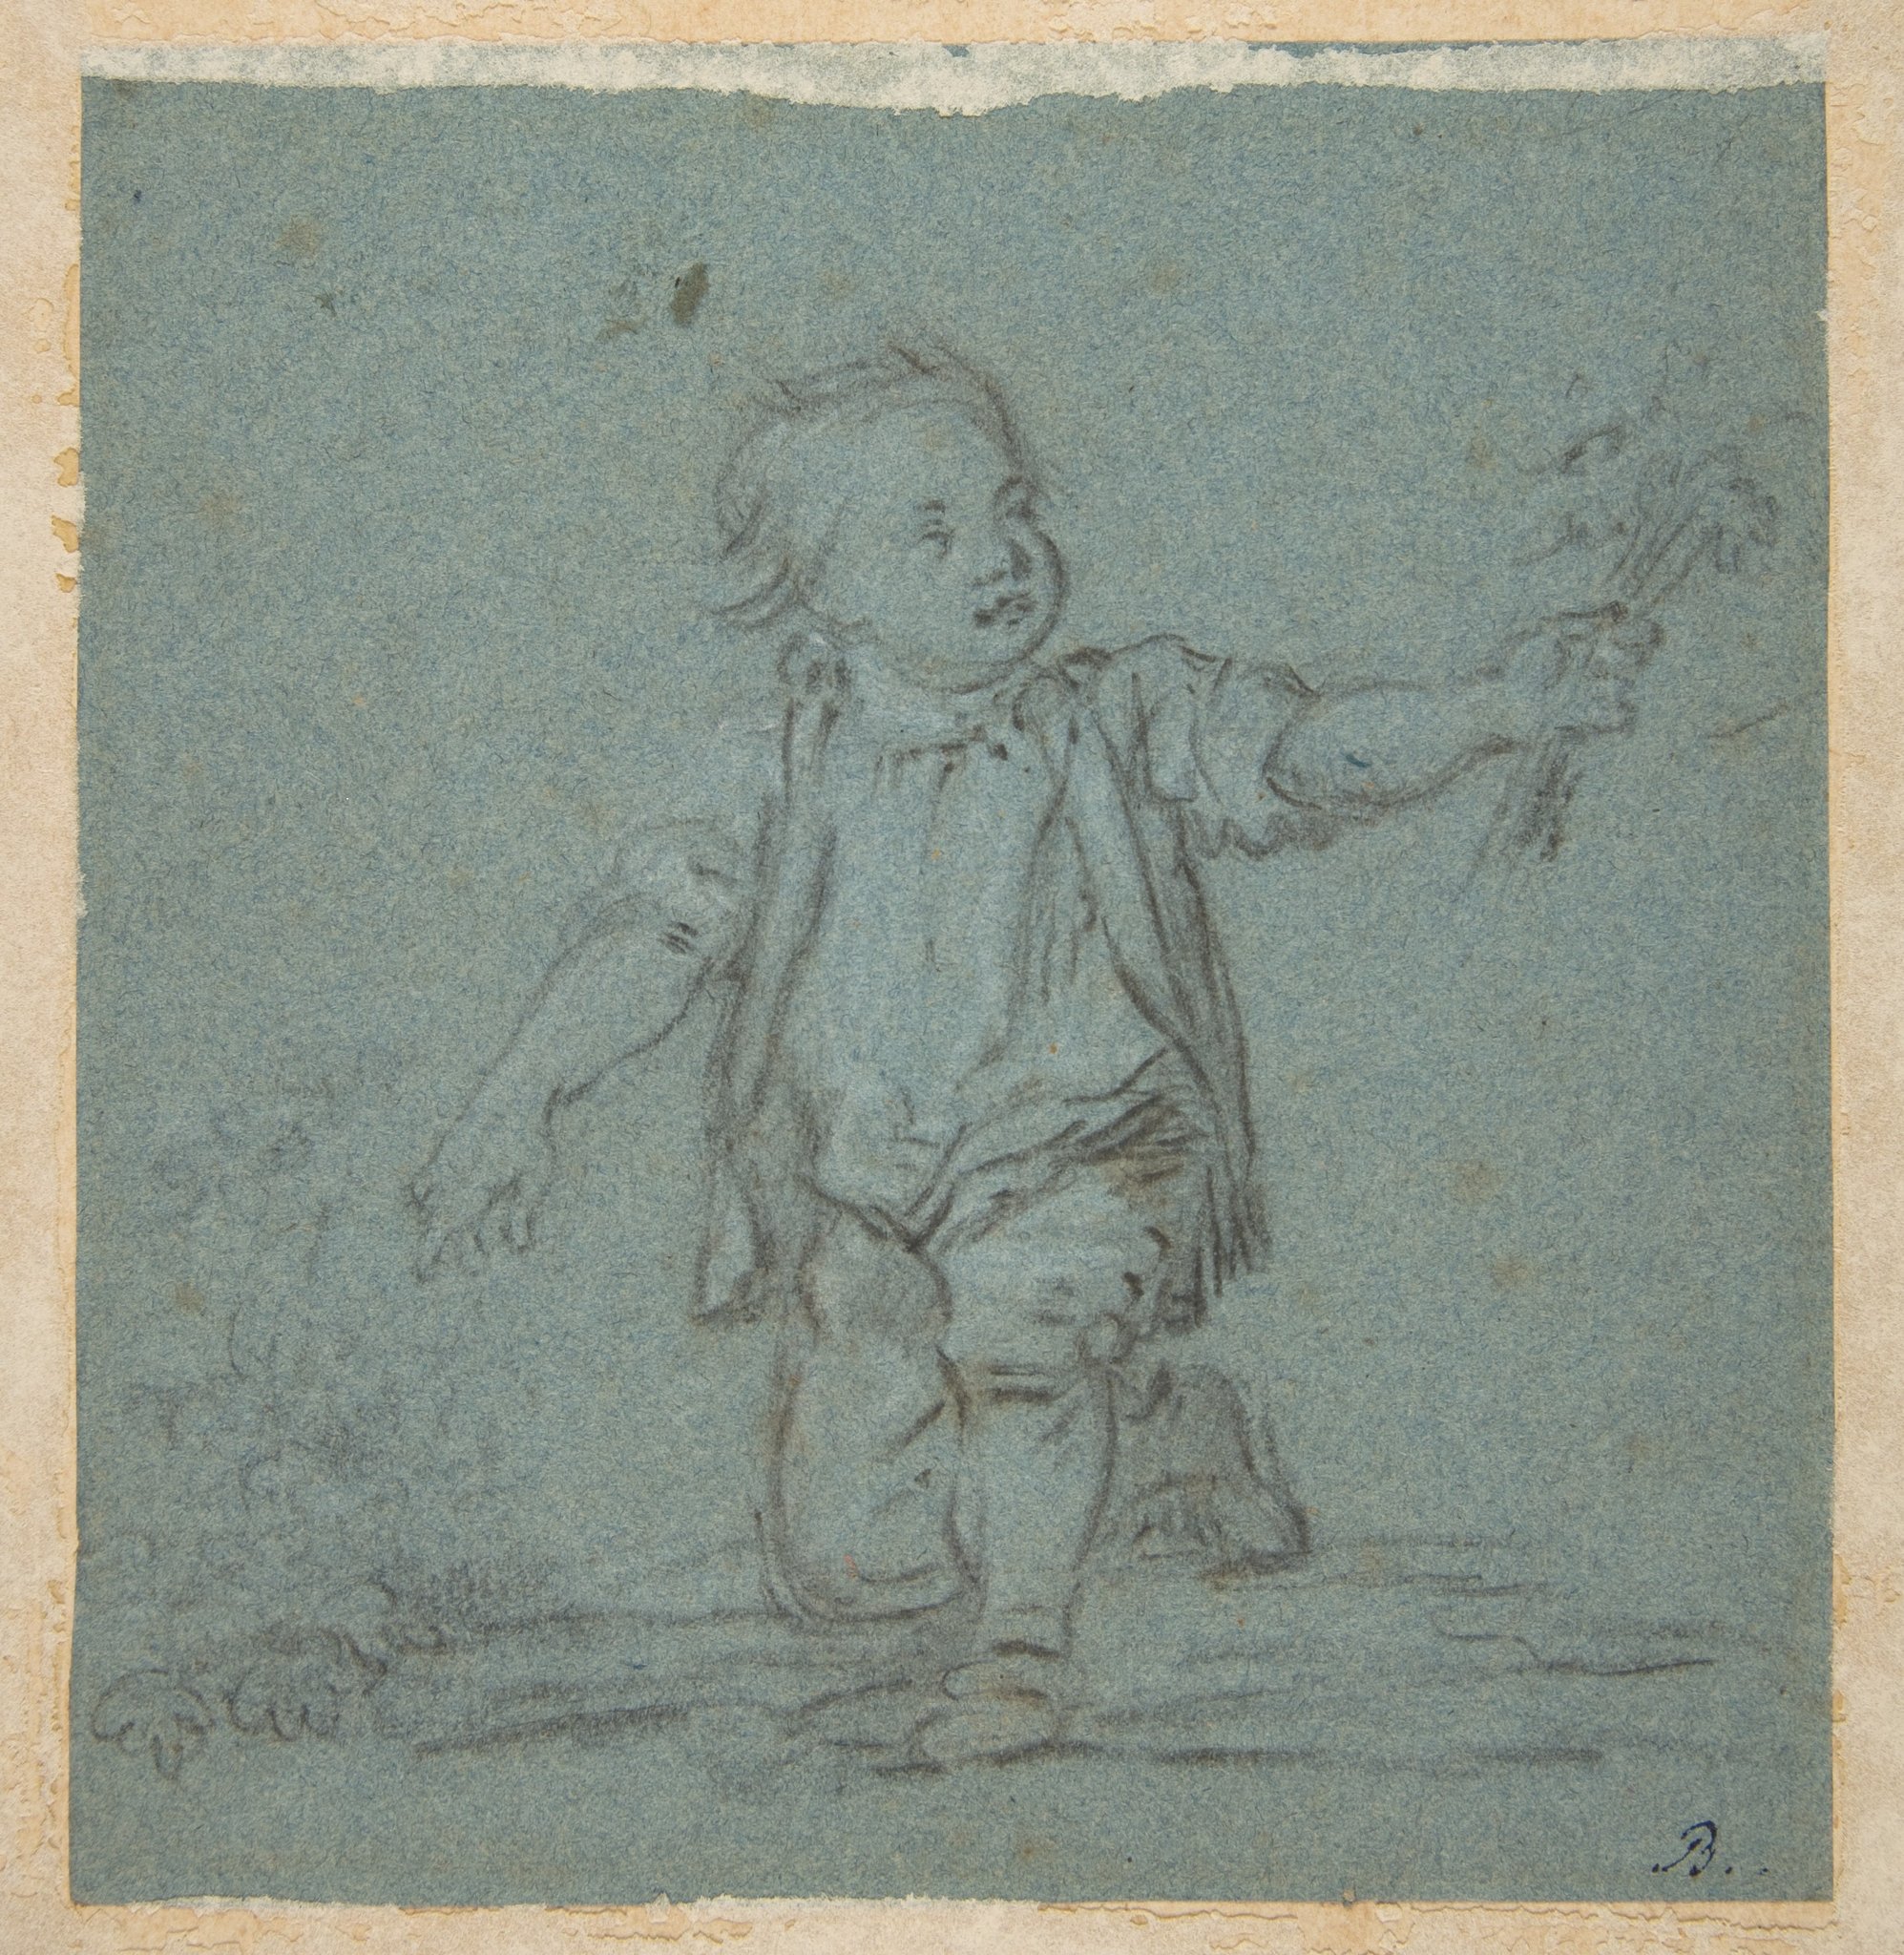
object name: drawing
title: Boy Holding Flowers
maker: anonymous, french, 18th century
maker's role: artist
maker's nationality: french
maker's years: 1700-1800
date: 1701-1800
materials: chalk, paper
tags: boys,running,flowers